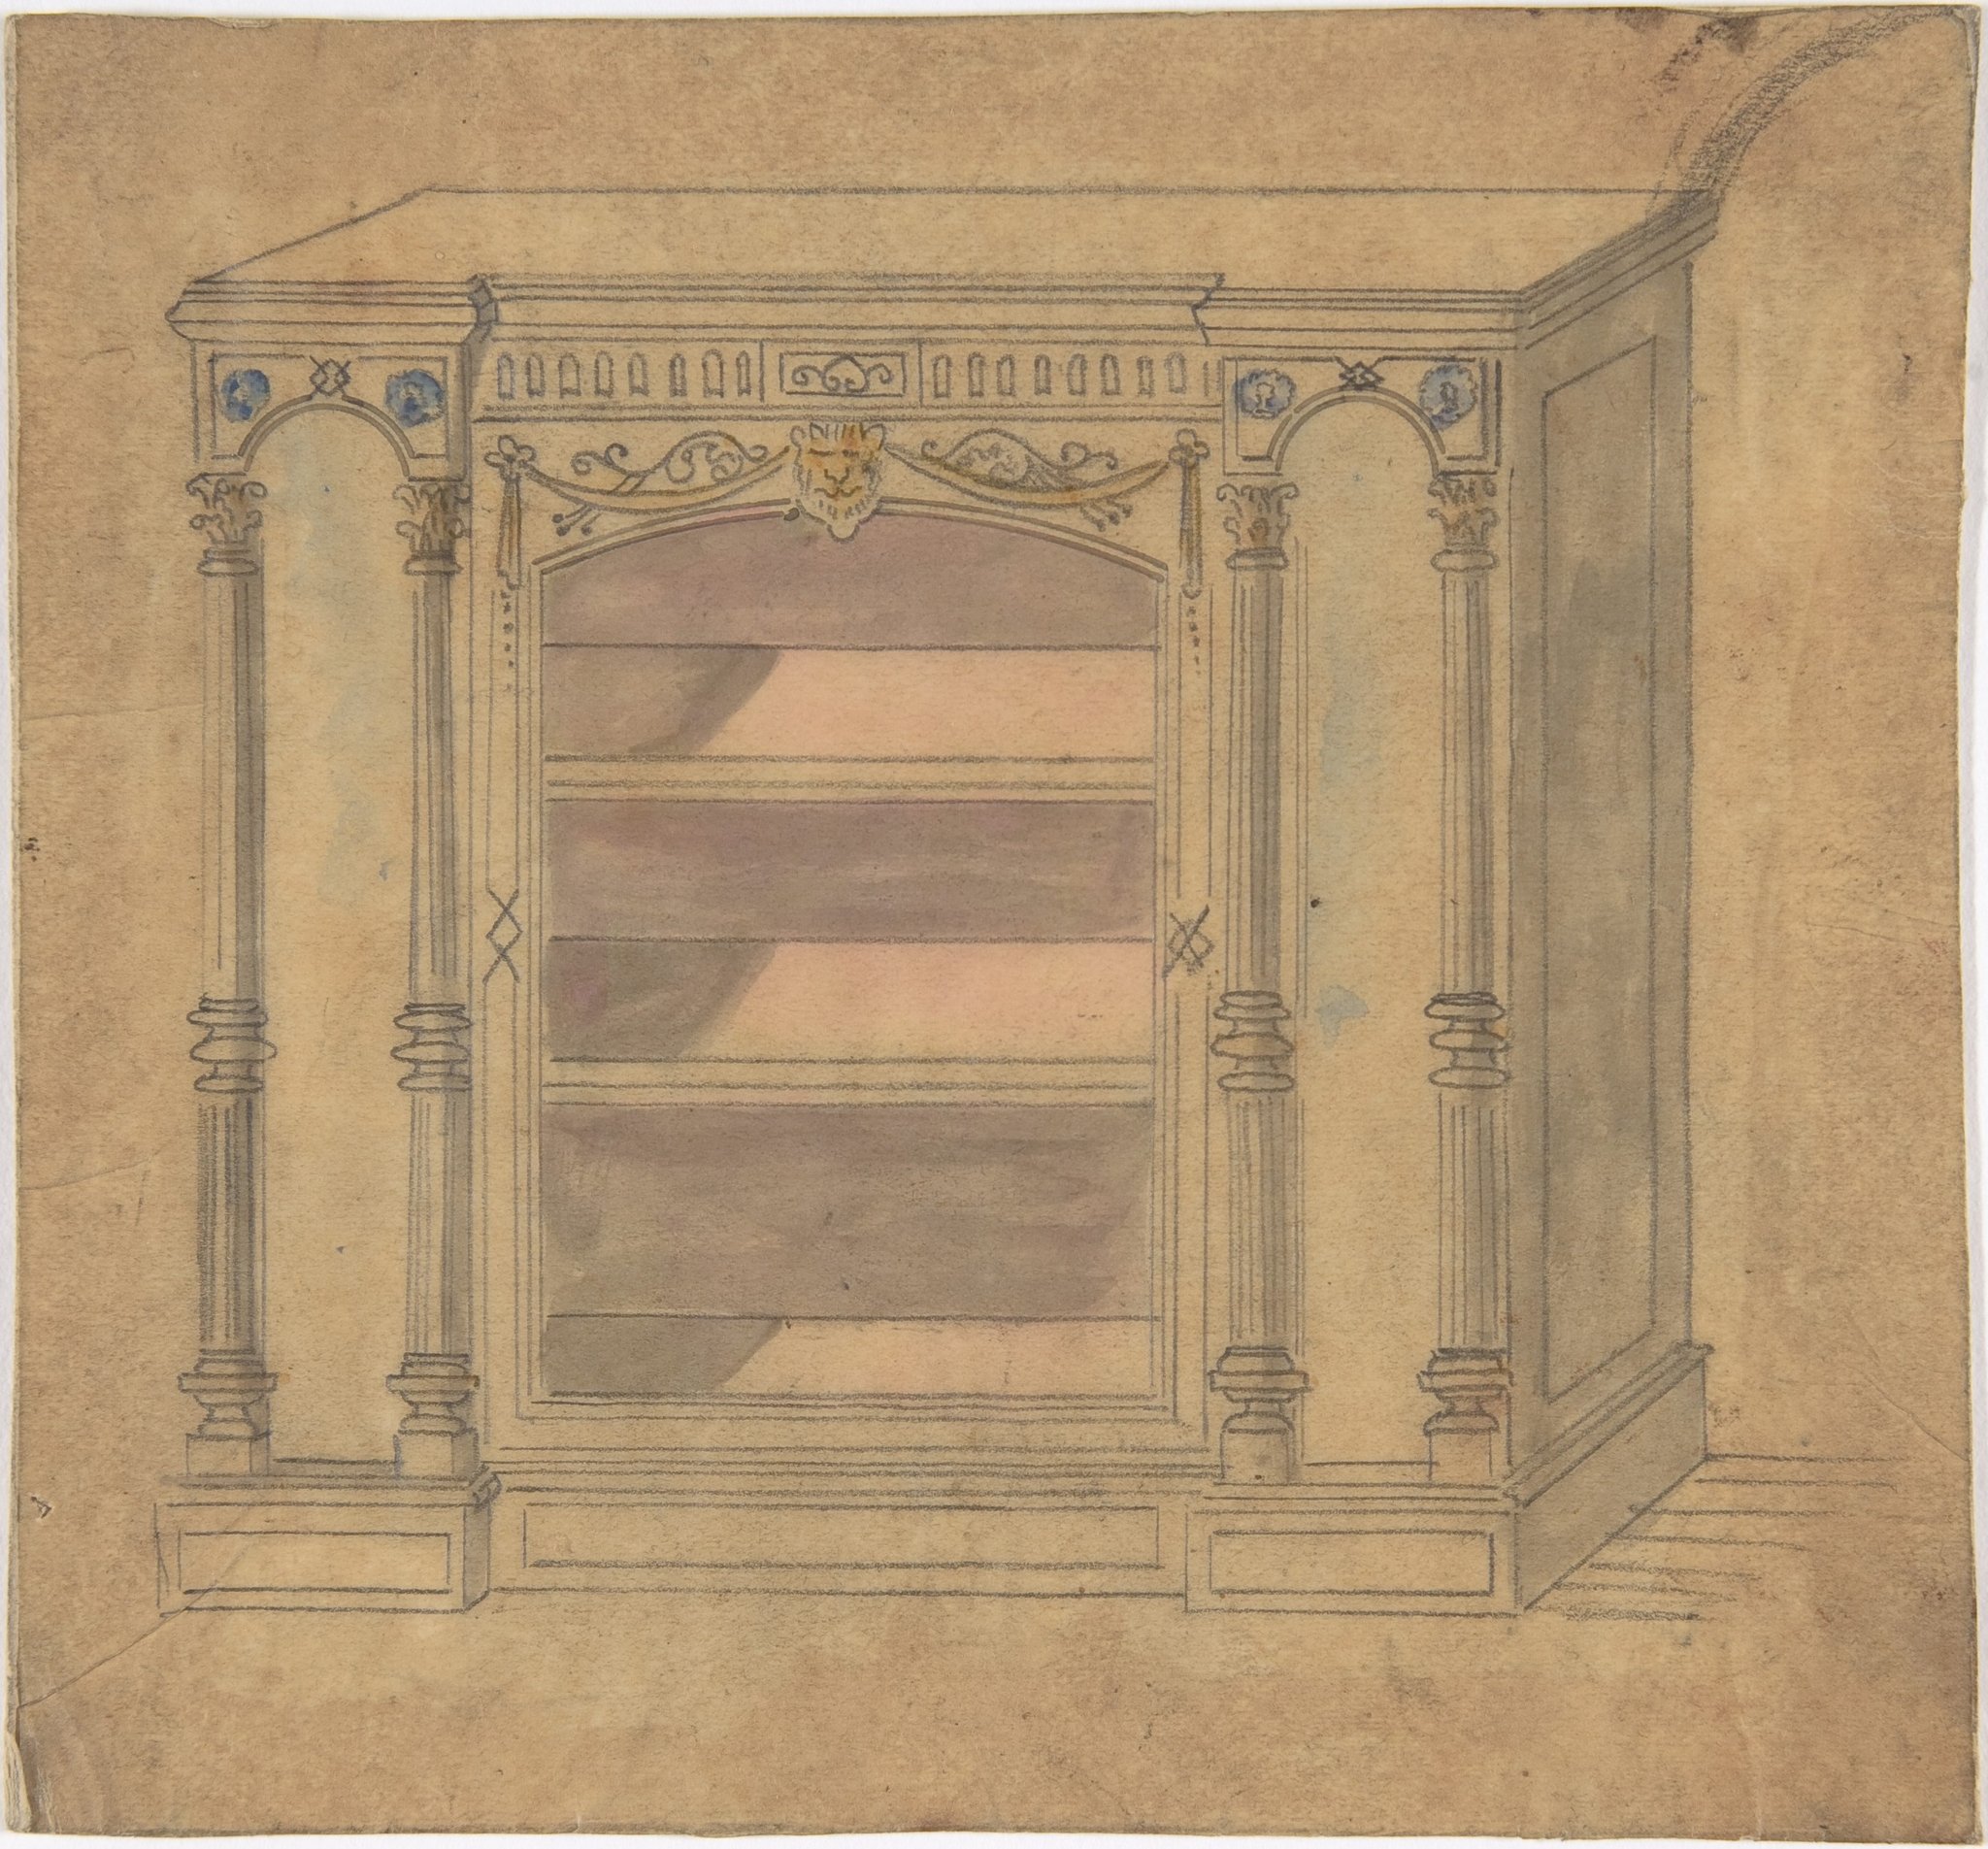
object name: drawing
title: Cabinet Design with Central Shelves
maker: anonymous, british, 19th century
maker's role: artist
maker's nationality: british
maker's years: 1800-1900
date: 1801-1900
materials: graphite, paper, watercolor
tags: cabinets